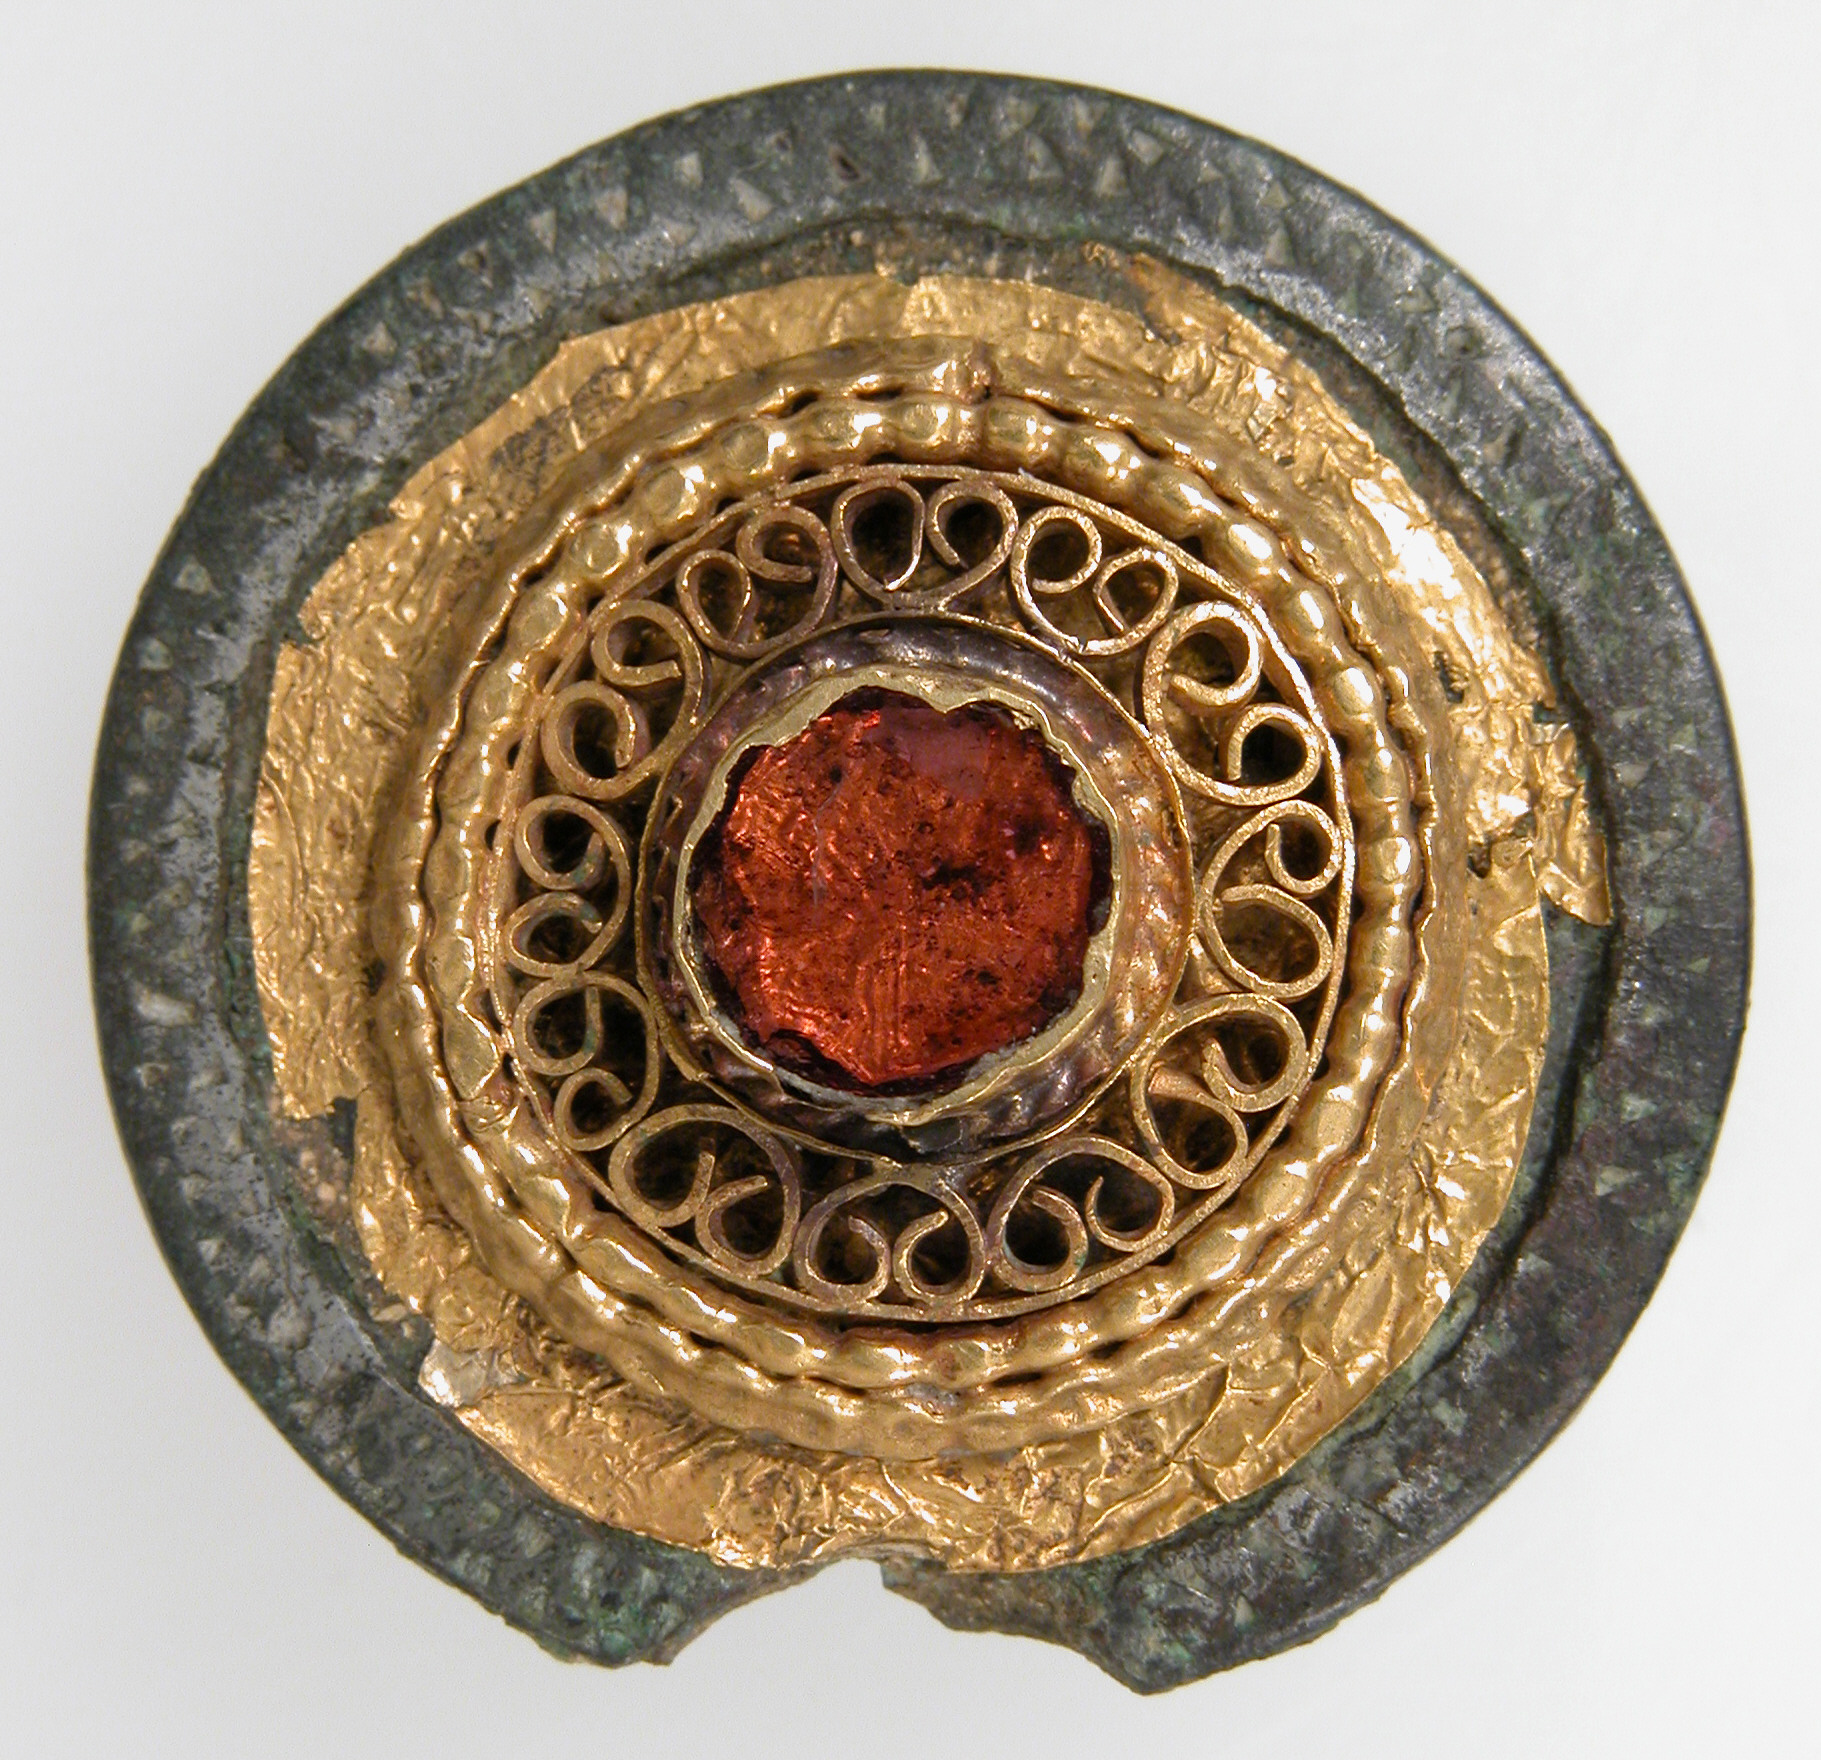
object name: brooch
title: Disk Brooch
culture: anglo-saxon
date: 601-700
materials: copper alloy, glass, gold, paste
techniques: silvered